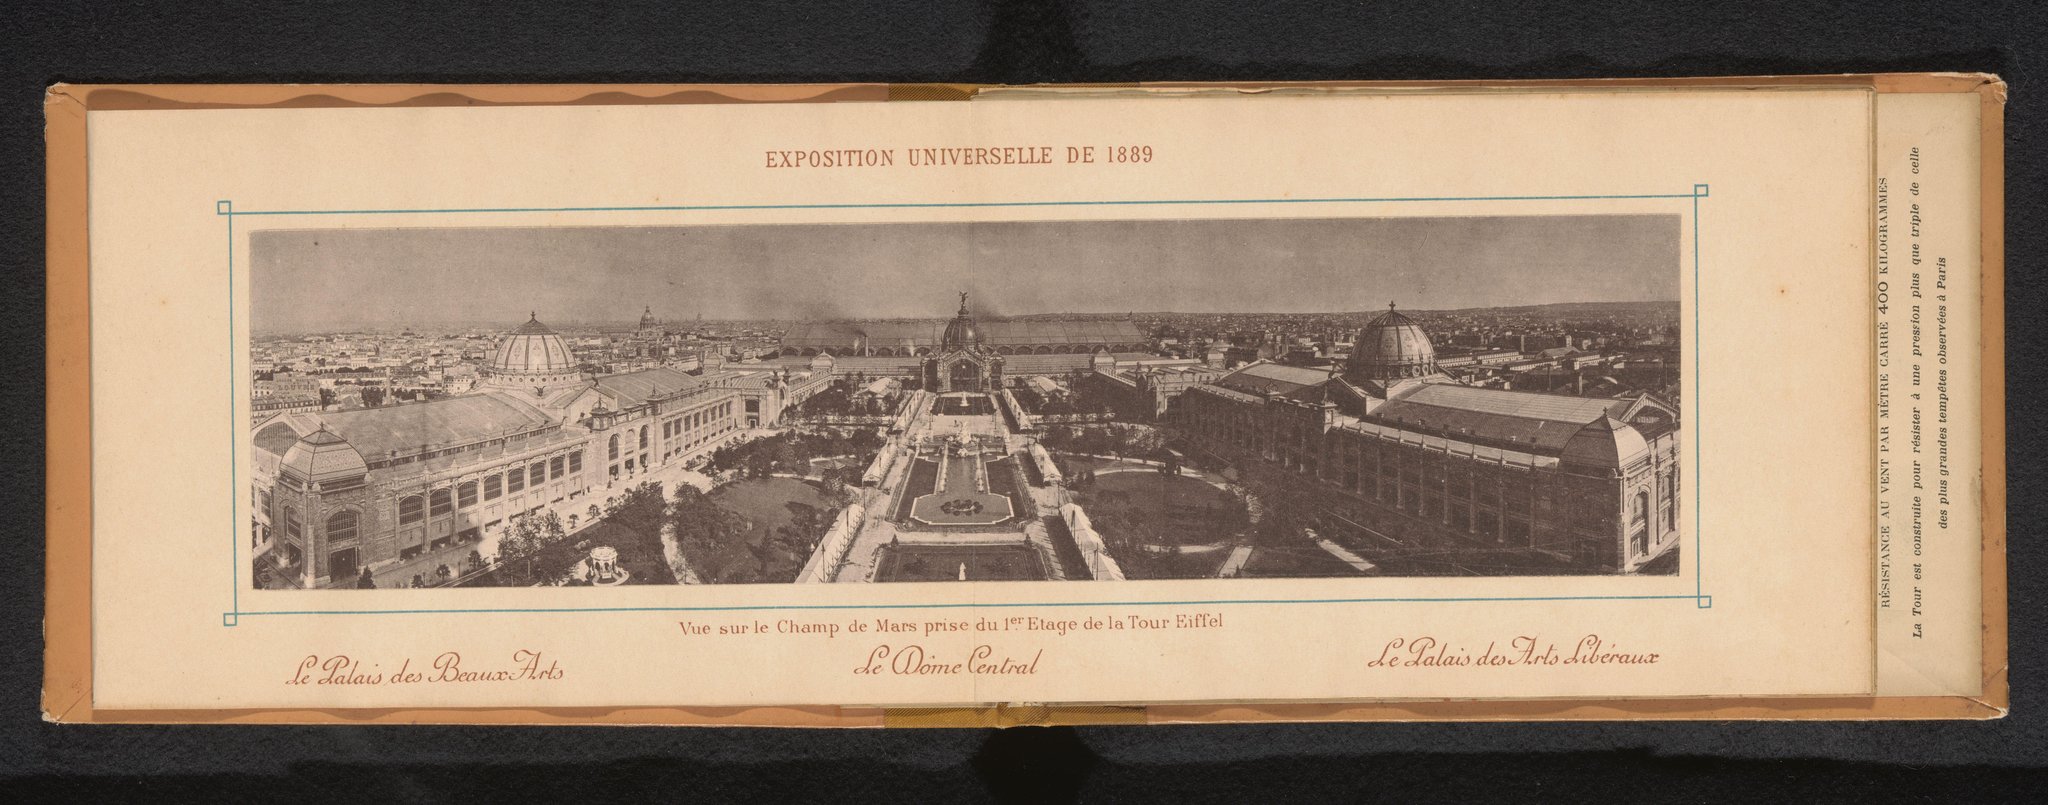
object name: page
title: Gezicht op de Champ-de-Mars in Parijs met het Palais des Beaux-Arts, het the Palais des Arts Libéraux en de centrale hal voor de Wereldtentoonstelling van 1889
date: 1889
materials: paper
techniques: photograph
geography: paris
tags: city-view, and landscape with man-made constructions, world fair, world exhibition